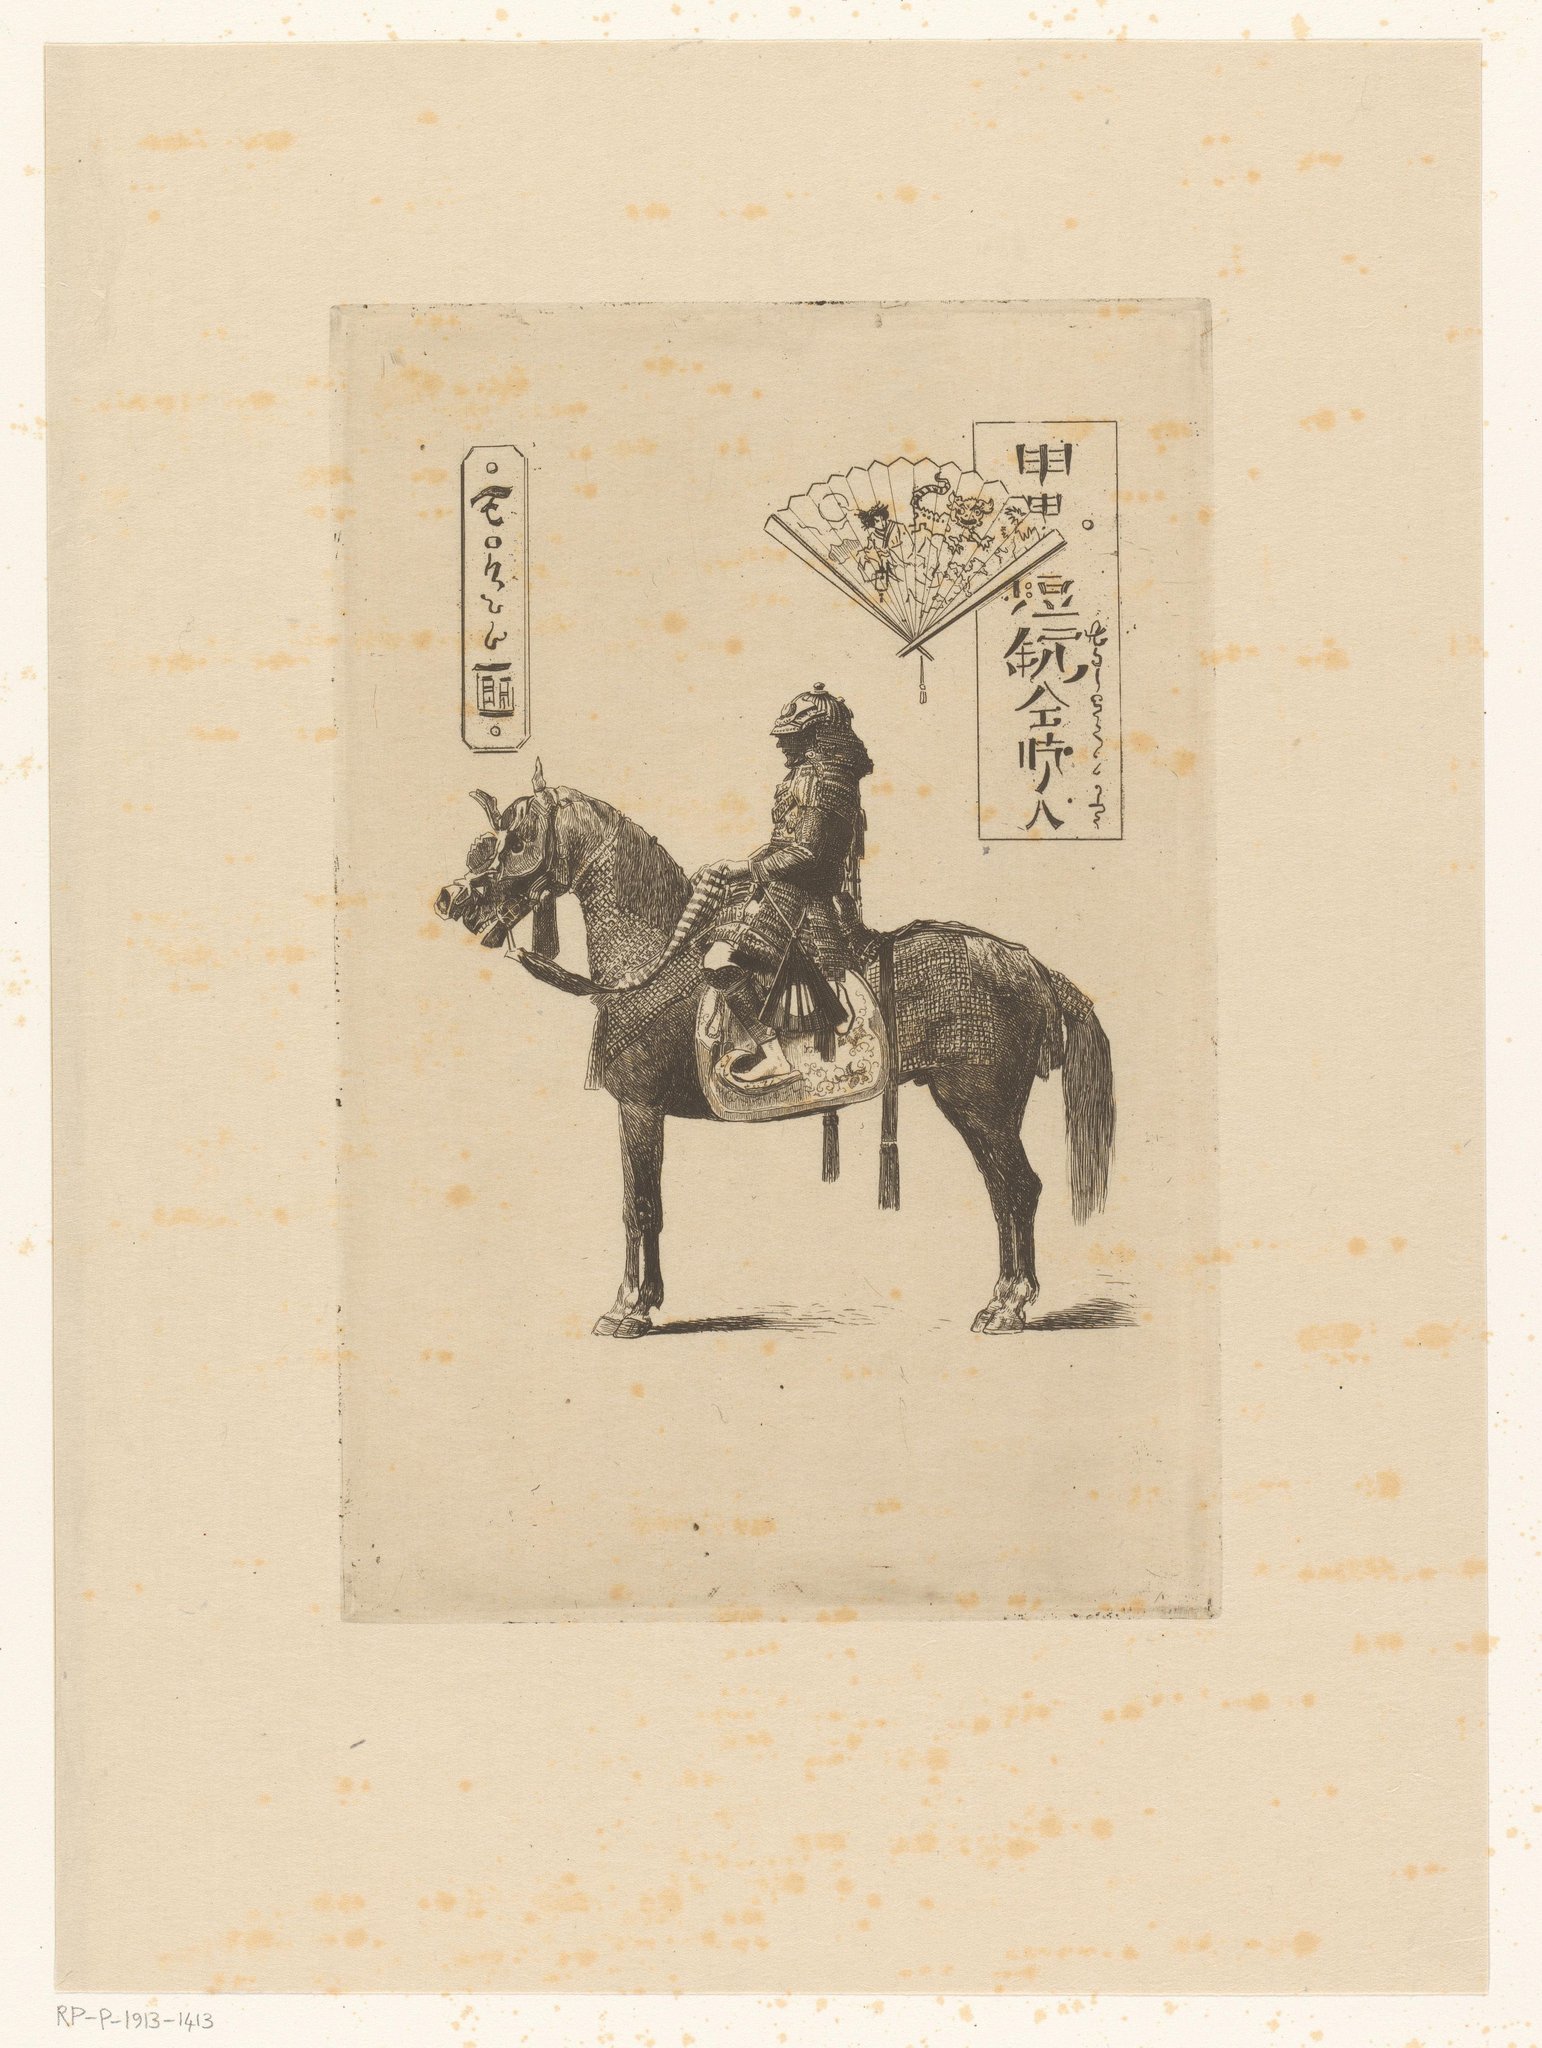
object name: print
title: Bronzen sculptuur van een samoerai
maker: félix hilaire buhot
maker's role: draughtsman, print maker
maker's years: 1847-1898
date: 1883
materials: paper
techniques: etching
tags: private soldier, piece of sculpture, reproduction of a piece of sculpture, japanese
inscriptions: collector's mark: Lugt 2233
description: Prent uit een serie bestaande uit acht platen plus titelprent en ex libris, naar Japanse objecten uit de collectie van Philippe Burty, uitgegeven in Parijs door Edmond Sagot in (april) 1883. In dat jaar vond er een belangrijke tentoonstelling plaats evenals andere Japan-georiënteerde activiteiten. Op 10 april 1883 opende de eerste retrospectieve tentoonstelling van Japanse kunst in de Westerse wereld in de Gallery Georges Petit op de Rue de Sèze te Parijs. Volgens een brief van Buhot aan Octave Uzanne, gedateerd 4 april 1883, had Buhot in 1875 reeds negen van de tien platen vervaardigd. Bourcard & Goodfriend vermelden dat er van de serie vijftig waren gedrukt op Japans papier, honderd op Nederlands papier en enkelen op geel met goud bewerkt papier. De eerste staat van deze plaat was linksonder 1874 gedateerd.